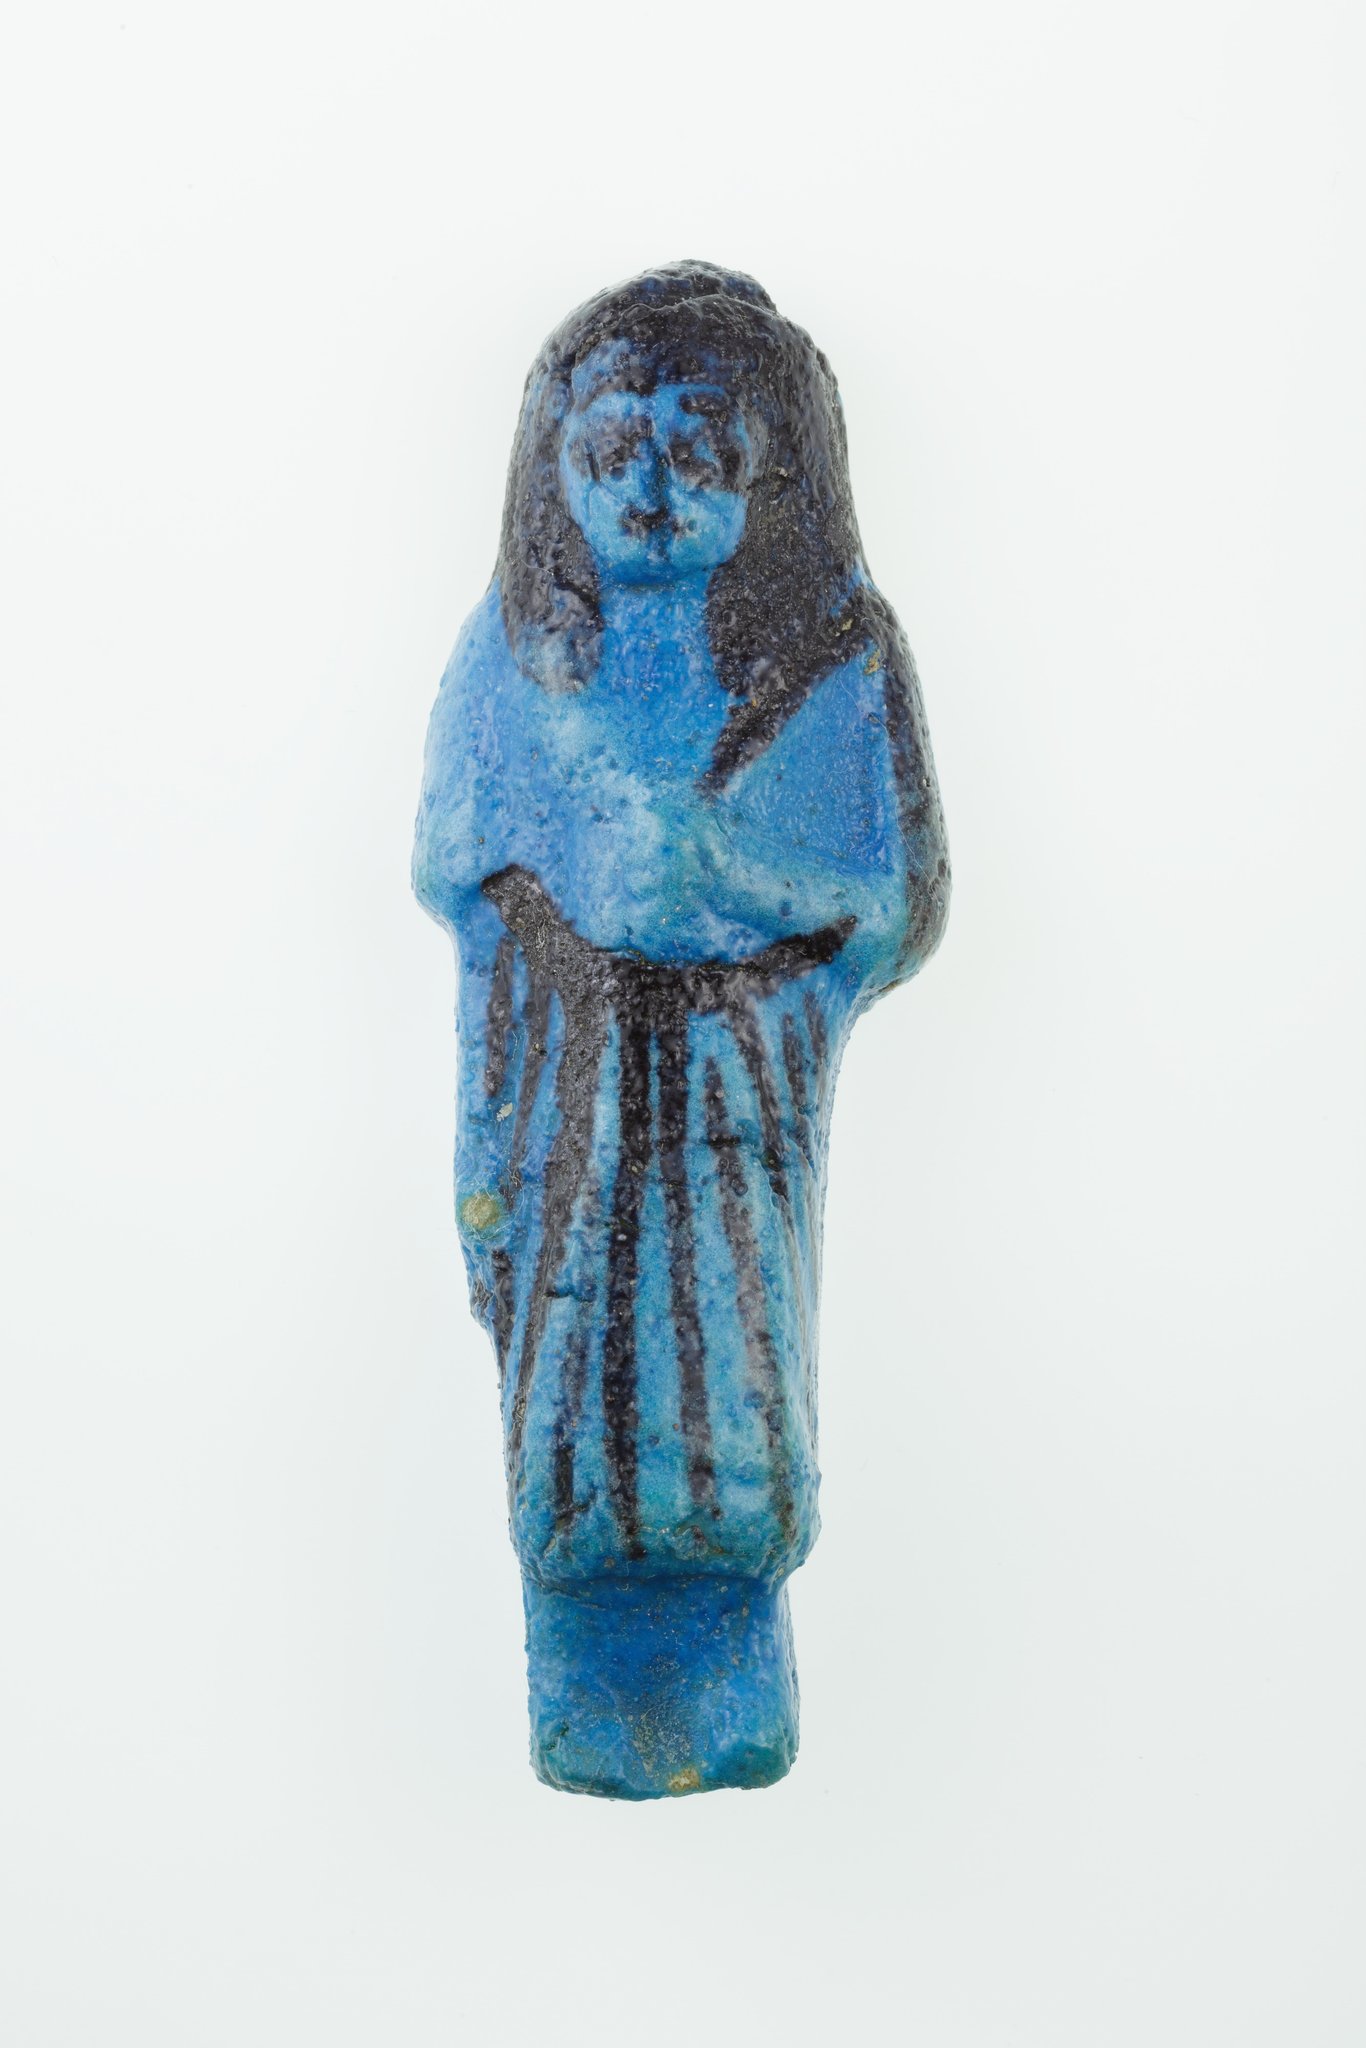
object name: shabti, overseer, nauny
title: Overseer Shabti of Nauny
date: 1050 BCE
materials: faience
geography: egypt